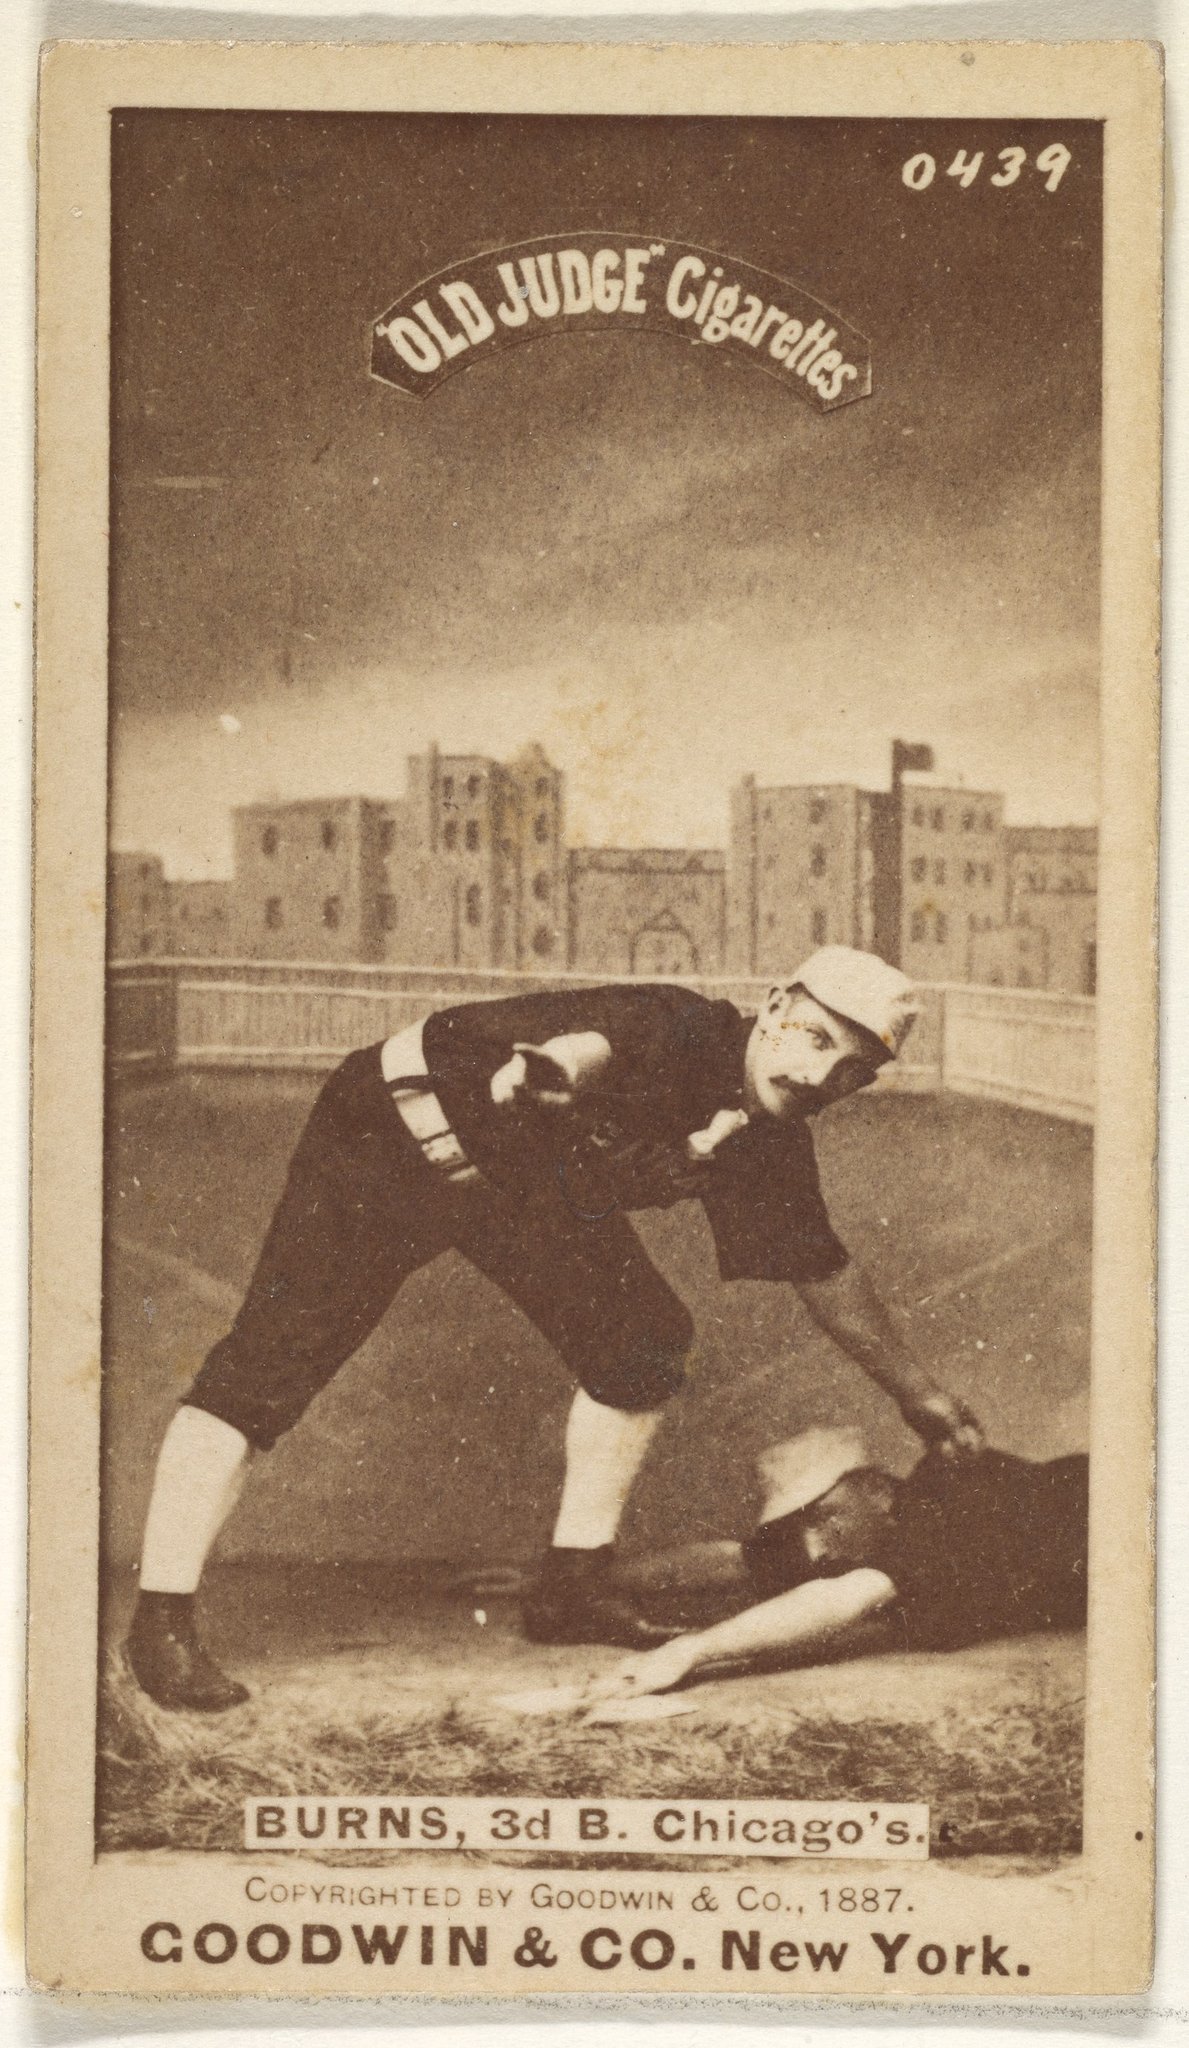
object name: baseball card, photograph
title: T.C. Burns, 3rd Base, Chicago, from the Old Judge series (N172) for Old Judge Cigarettes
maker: goodwin & company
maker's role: publisher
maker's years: 1850-1950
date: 1887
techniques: albumen silver print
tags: men,portraits,baseball,athletes